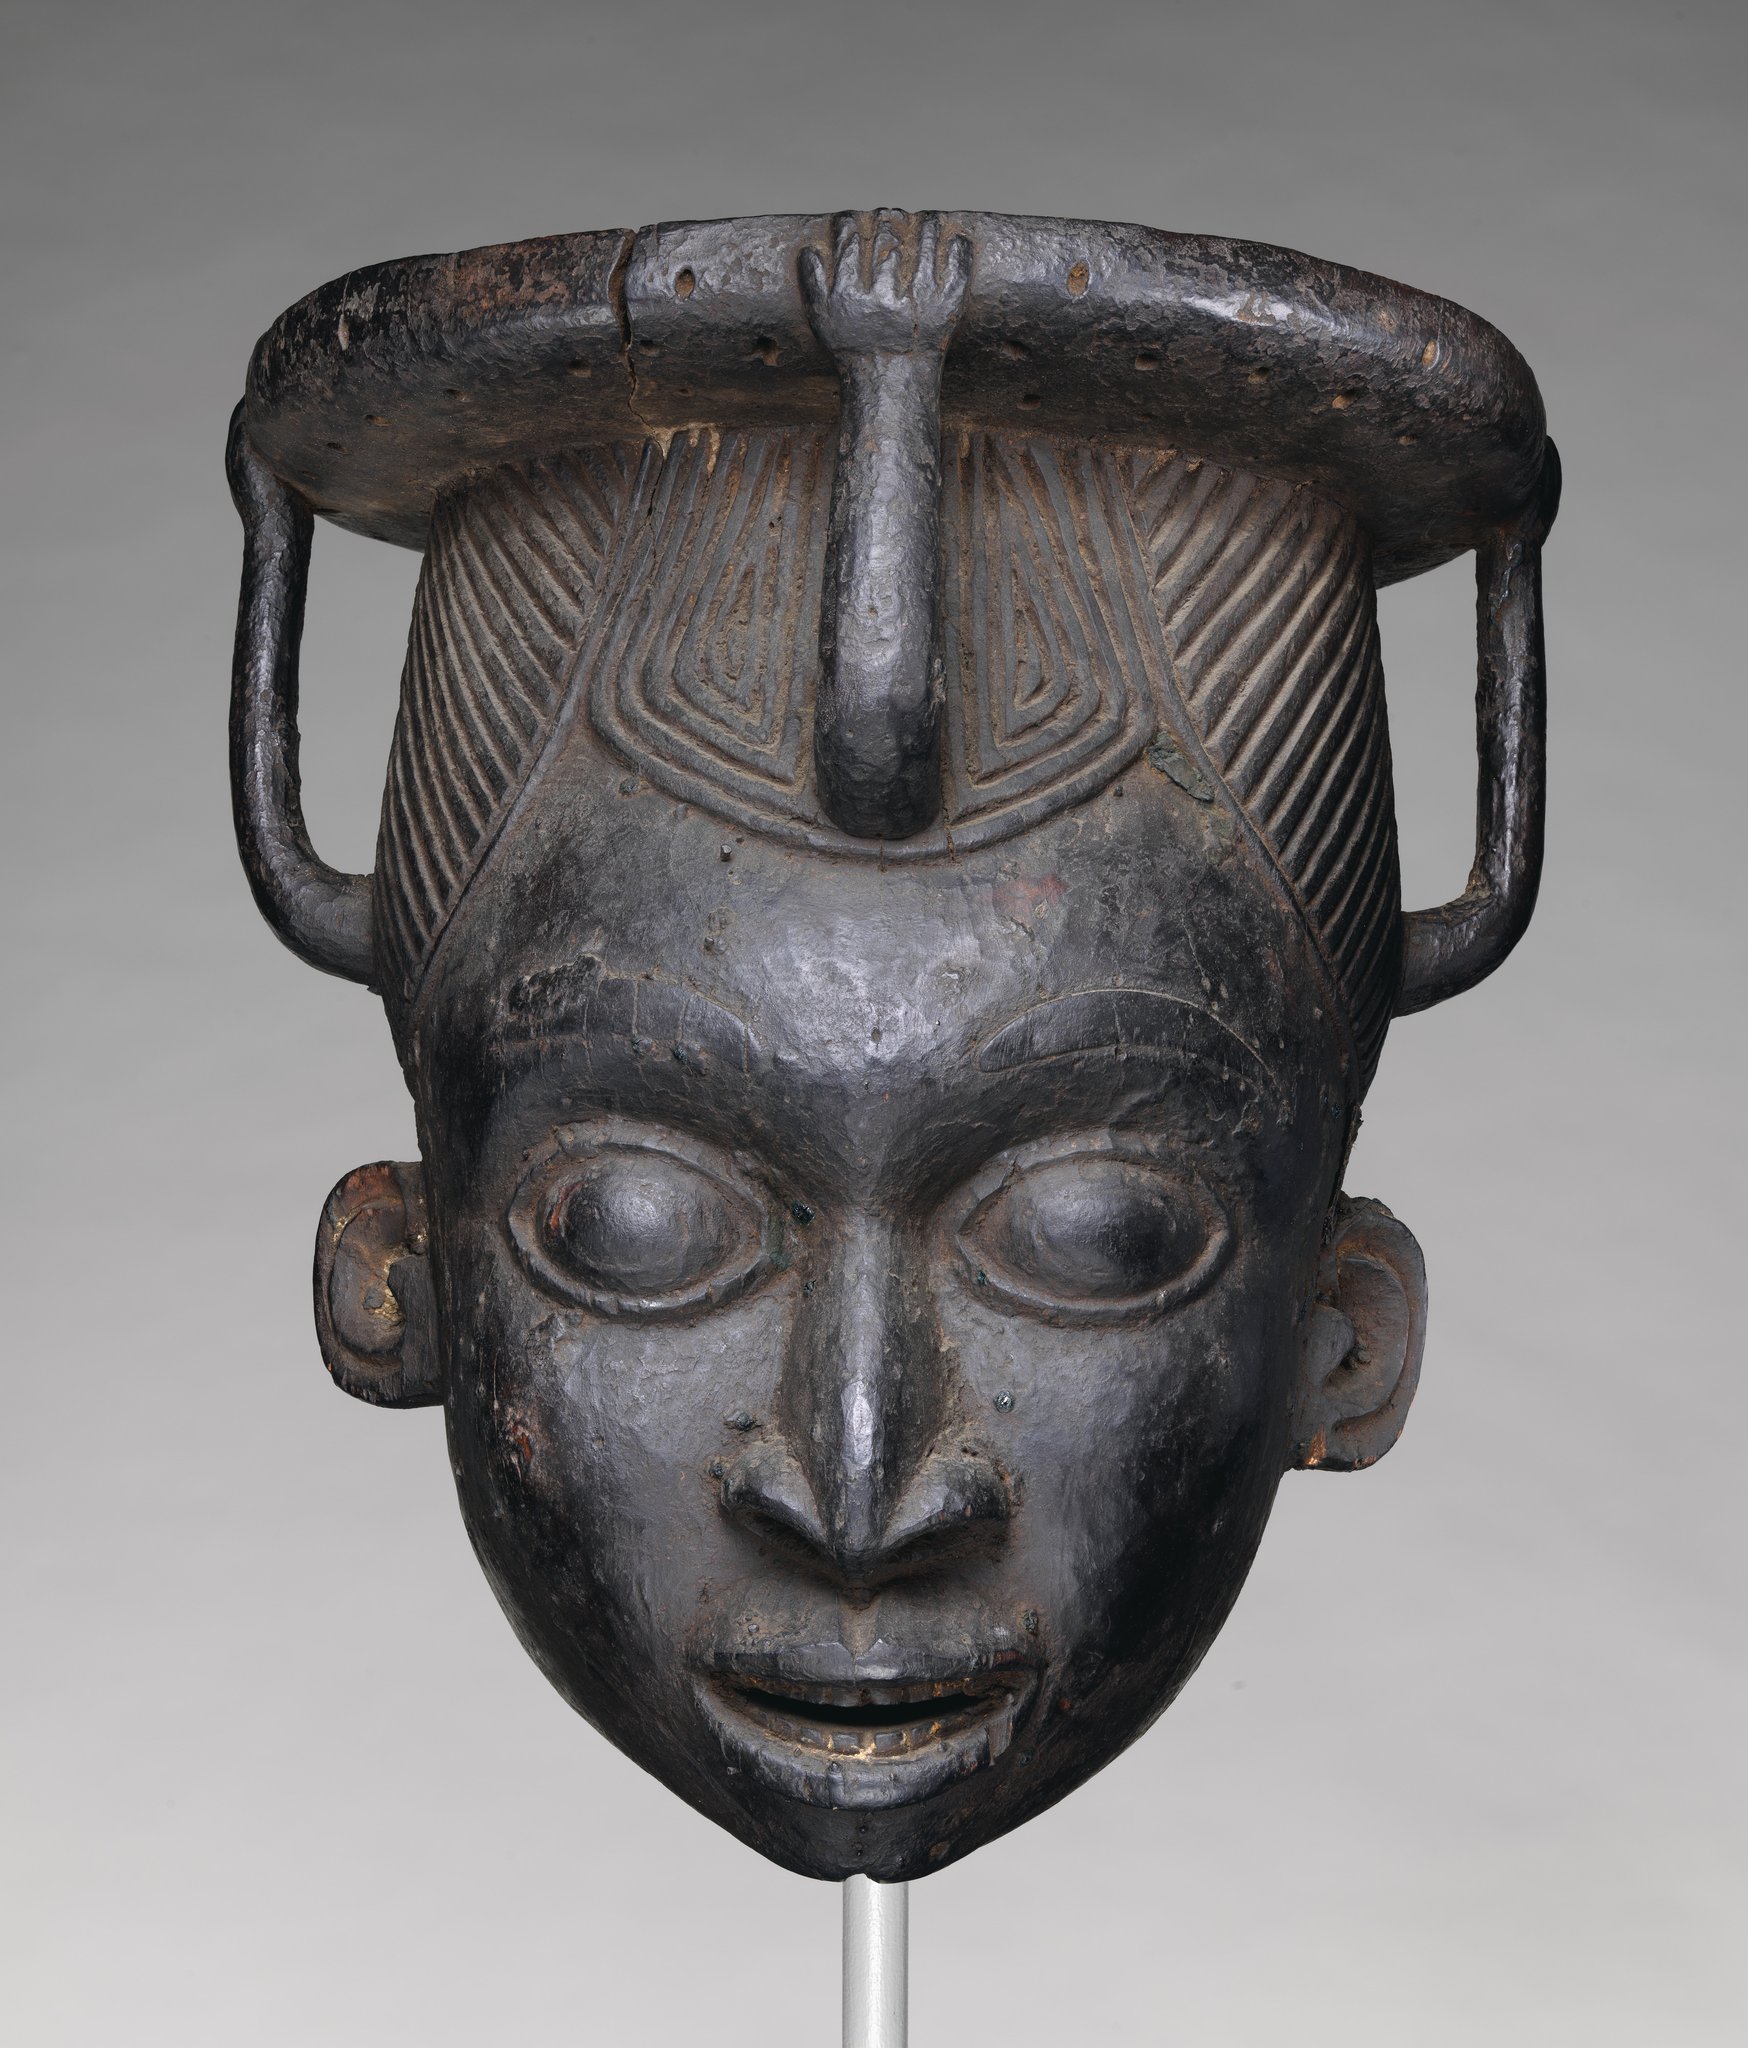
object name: mask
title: Helmet crest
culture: kom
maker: grassfields artist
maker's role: artist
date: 1830-1855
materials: copper, iron, pigment, wax, wood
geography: cameroon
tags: hands,heads